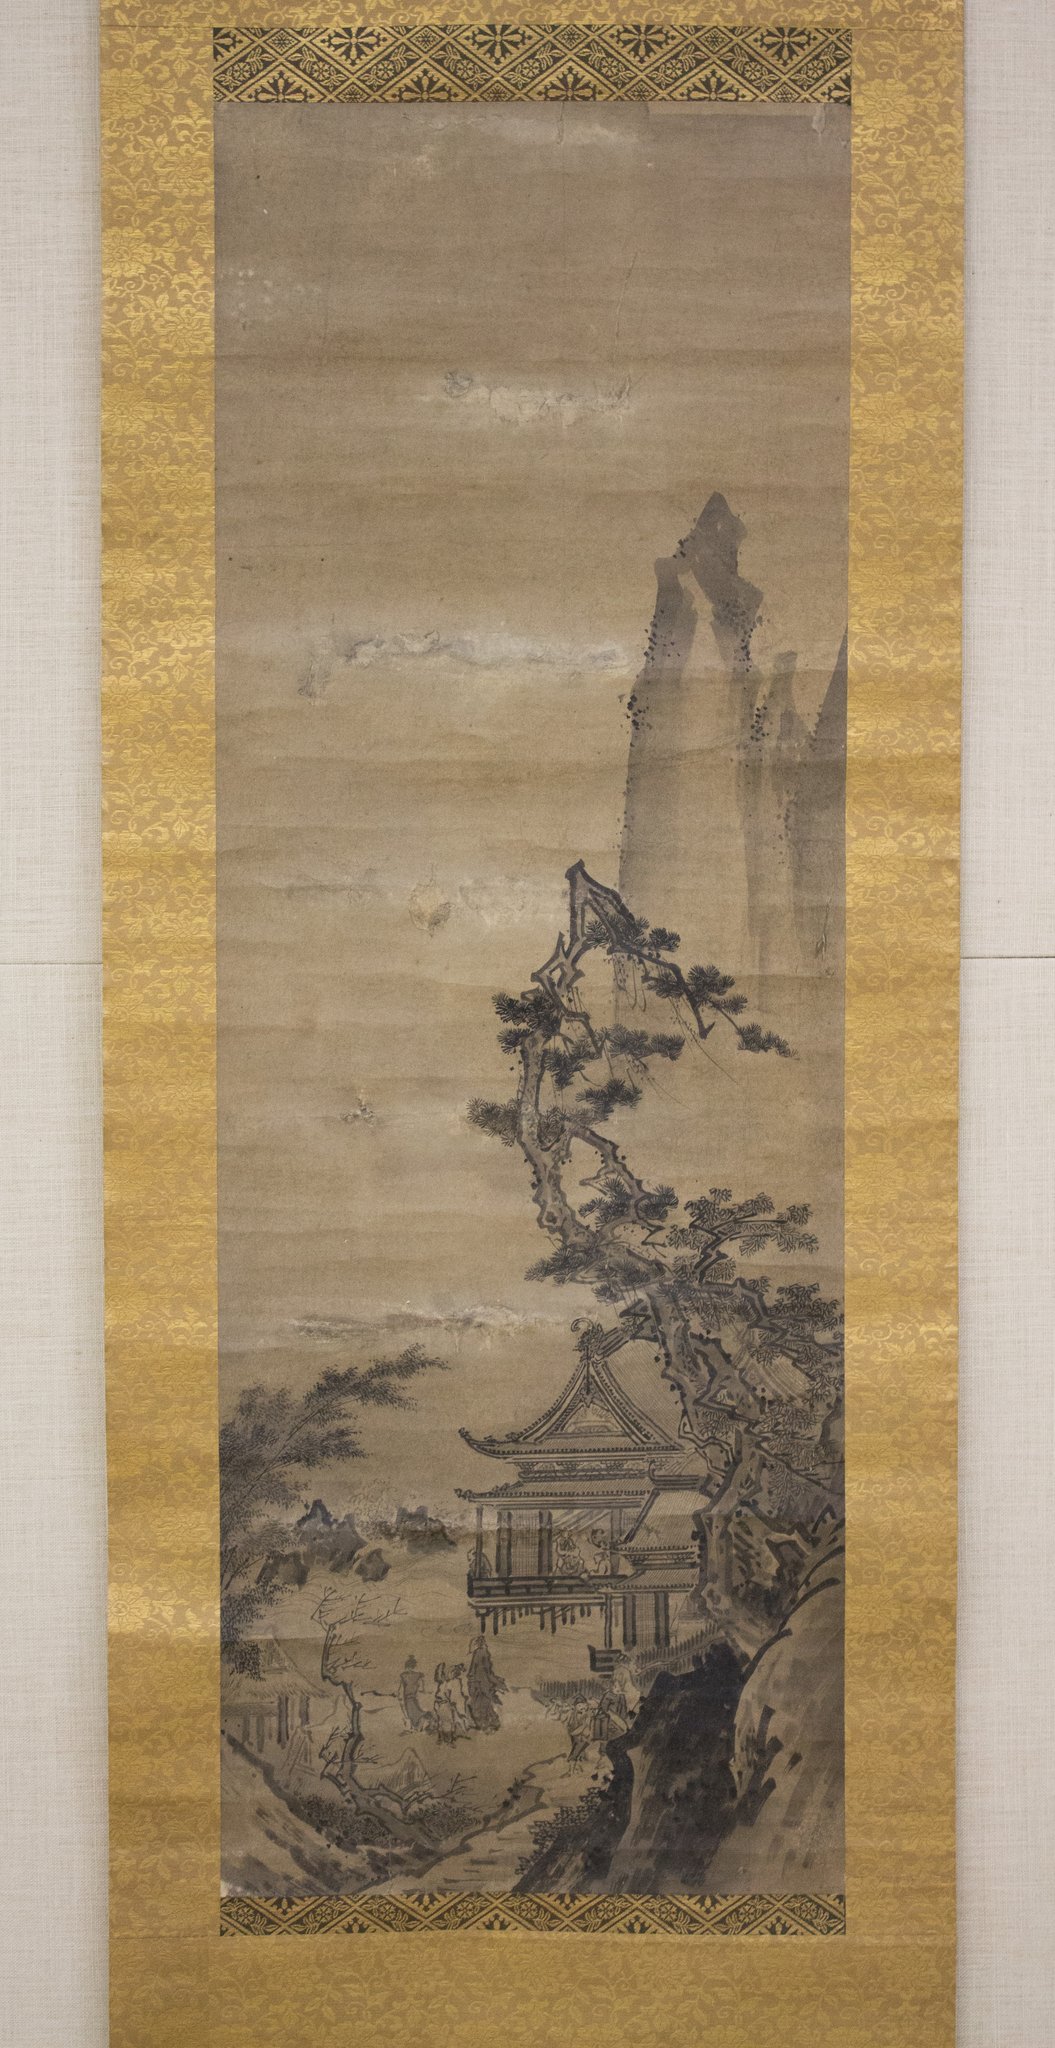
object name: hanging scroll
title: Pavilion on Mountain Stream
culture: japanese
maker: sesshū tōyō 雪舟等楊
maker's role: artist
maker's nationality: japanese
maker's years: 1420-1506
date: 1601-1700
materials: ink, paper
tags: mountains,landscapes,pavilions